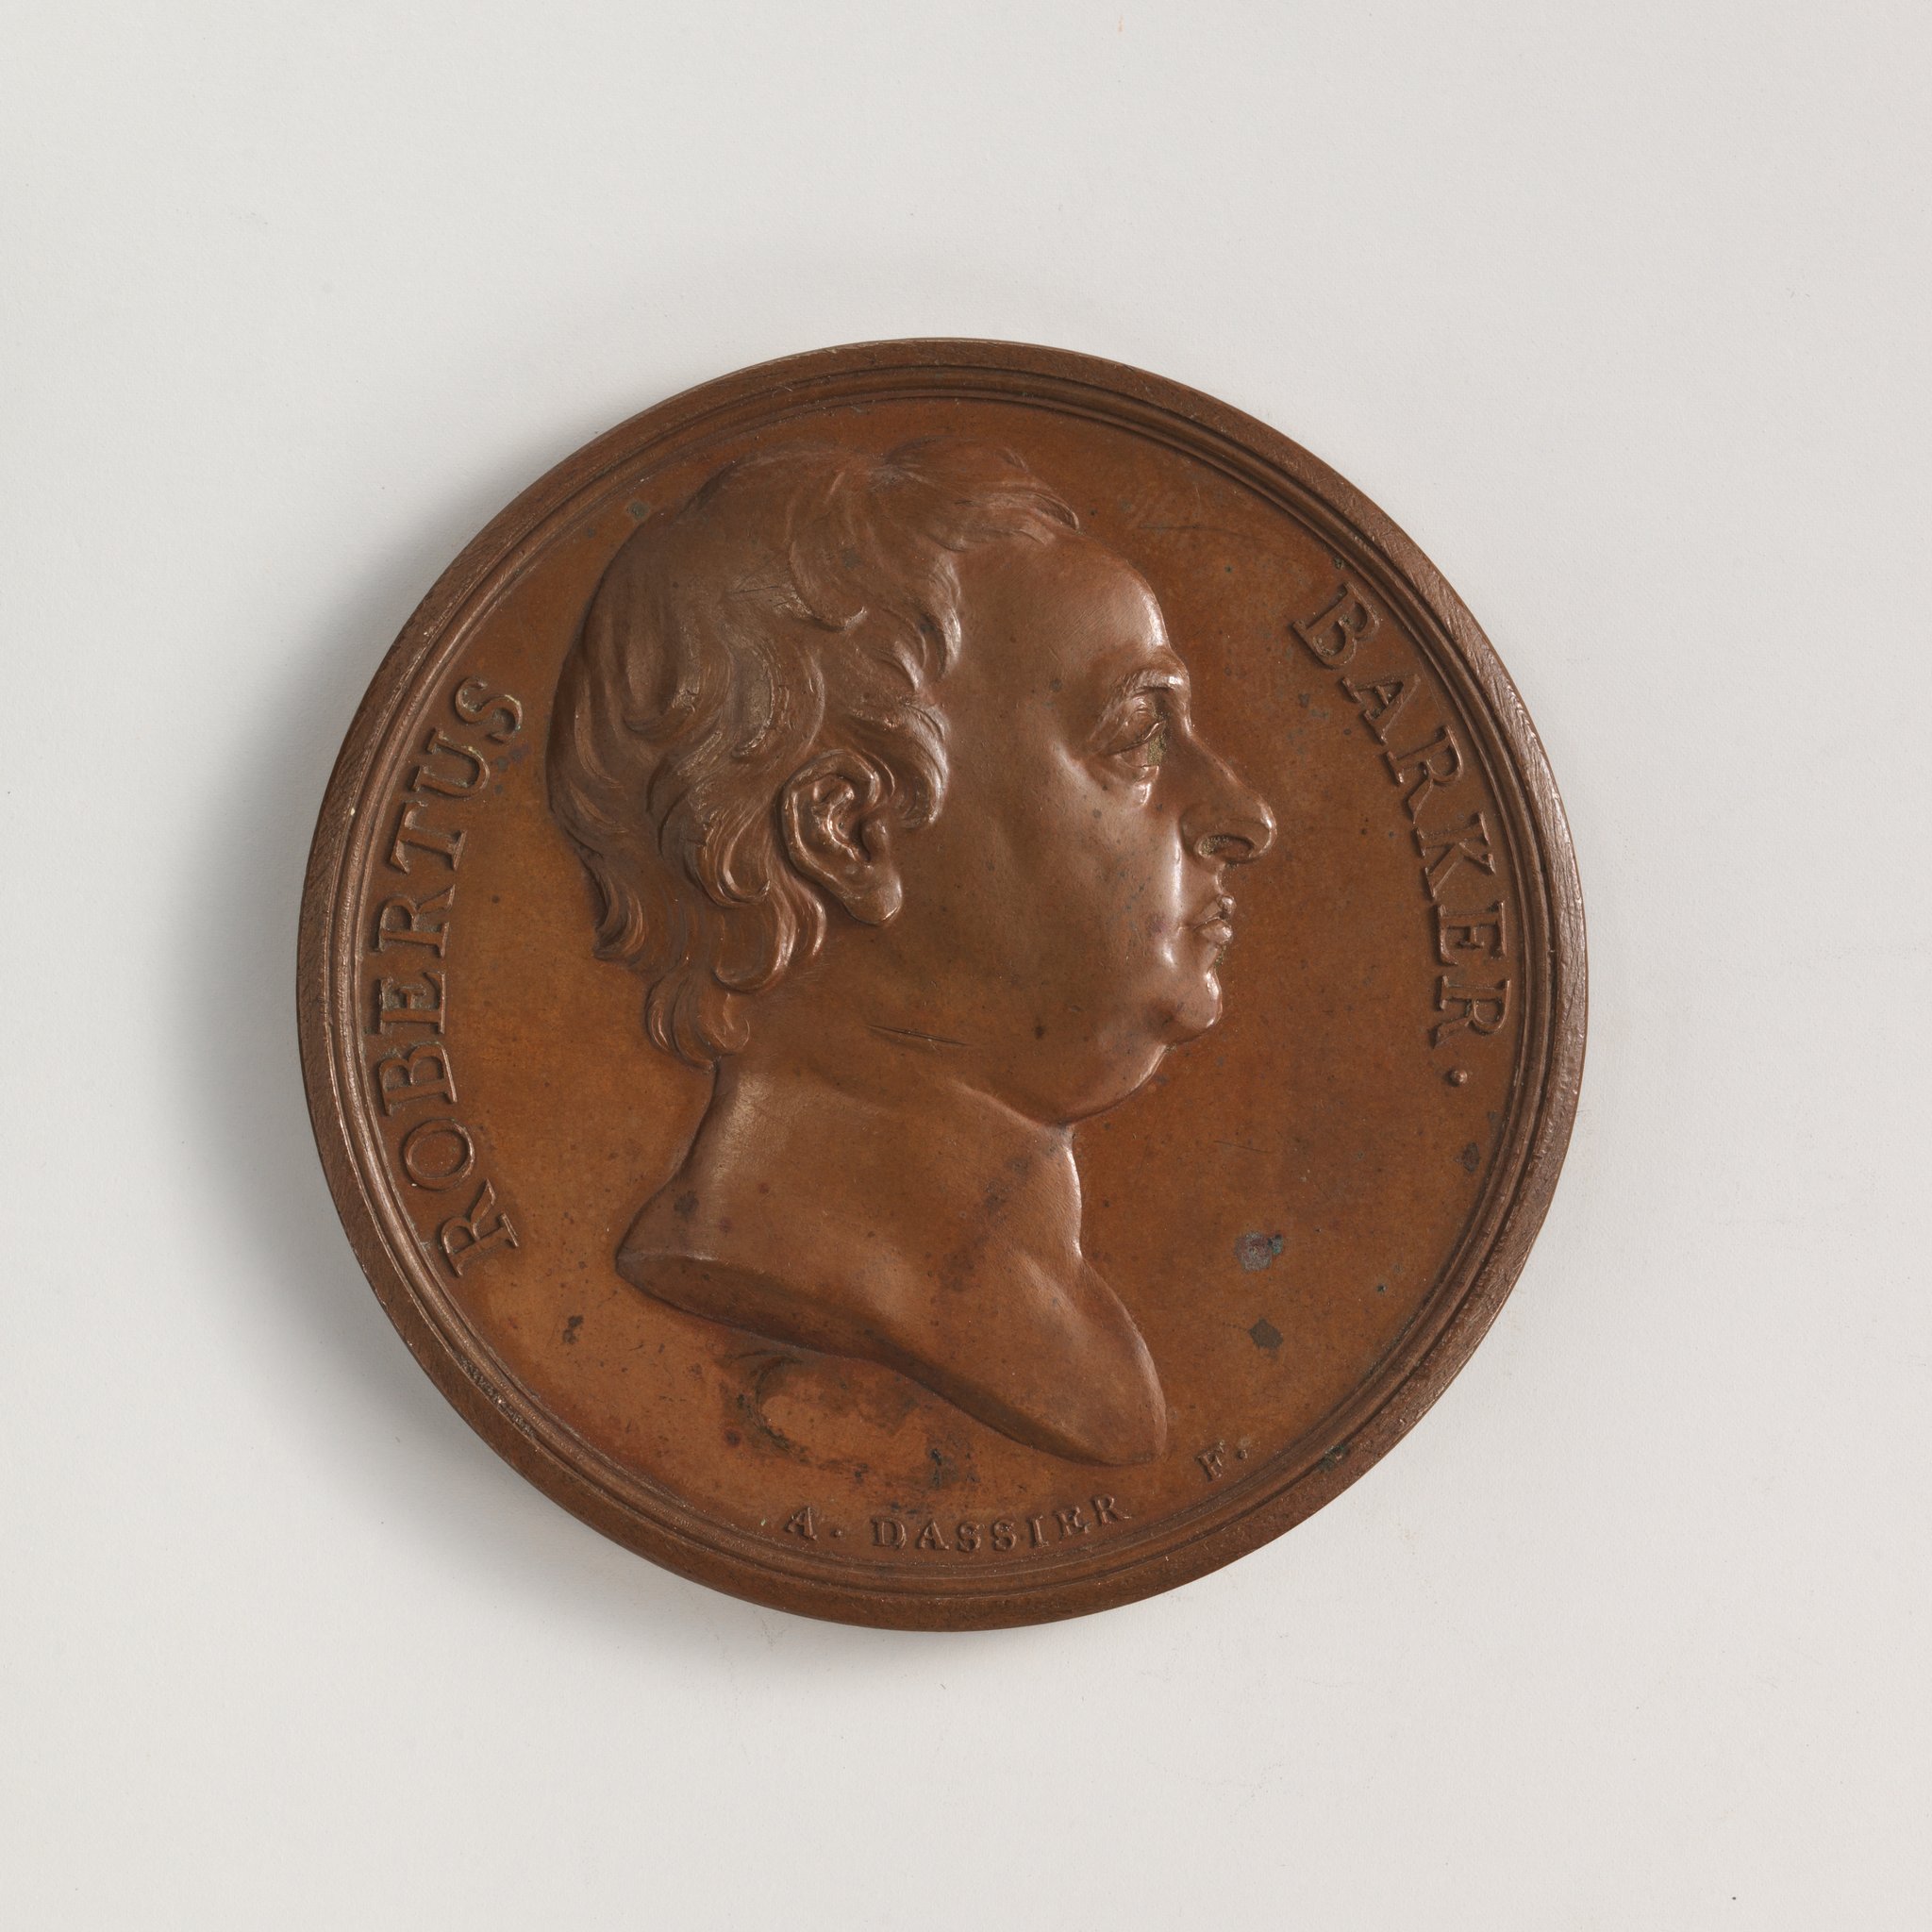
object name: medal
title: Robert Barker (d. 1745)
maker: jacques-antoine dassier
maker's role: artist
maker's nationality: swiss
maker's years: 1715-1759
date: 1744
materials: bronze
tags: men,profiles